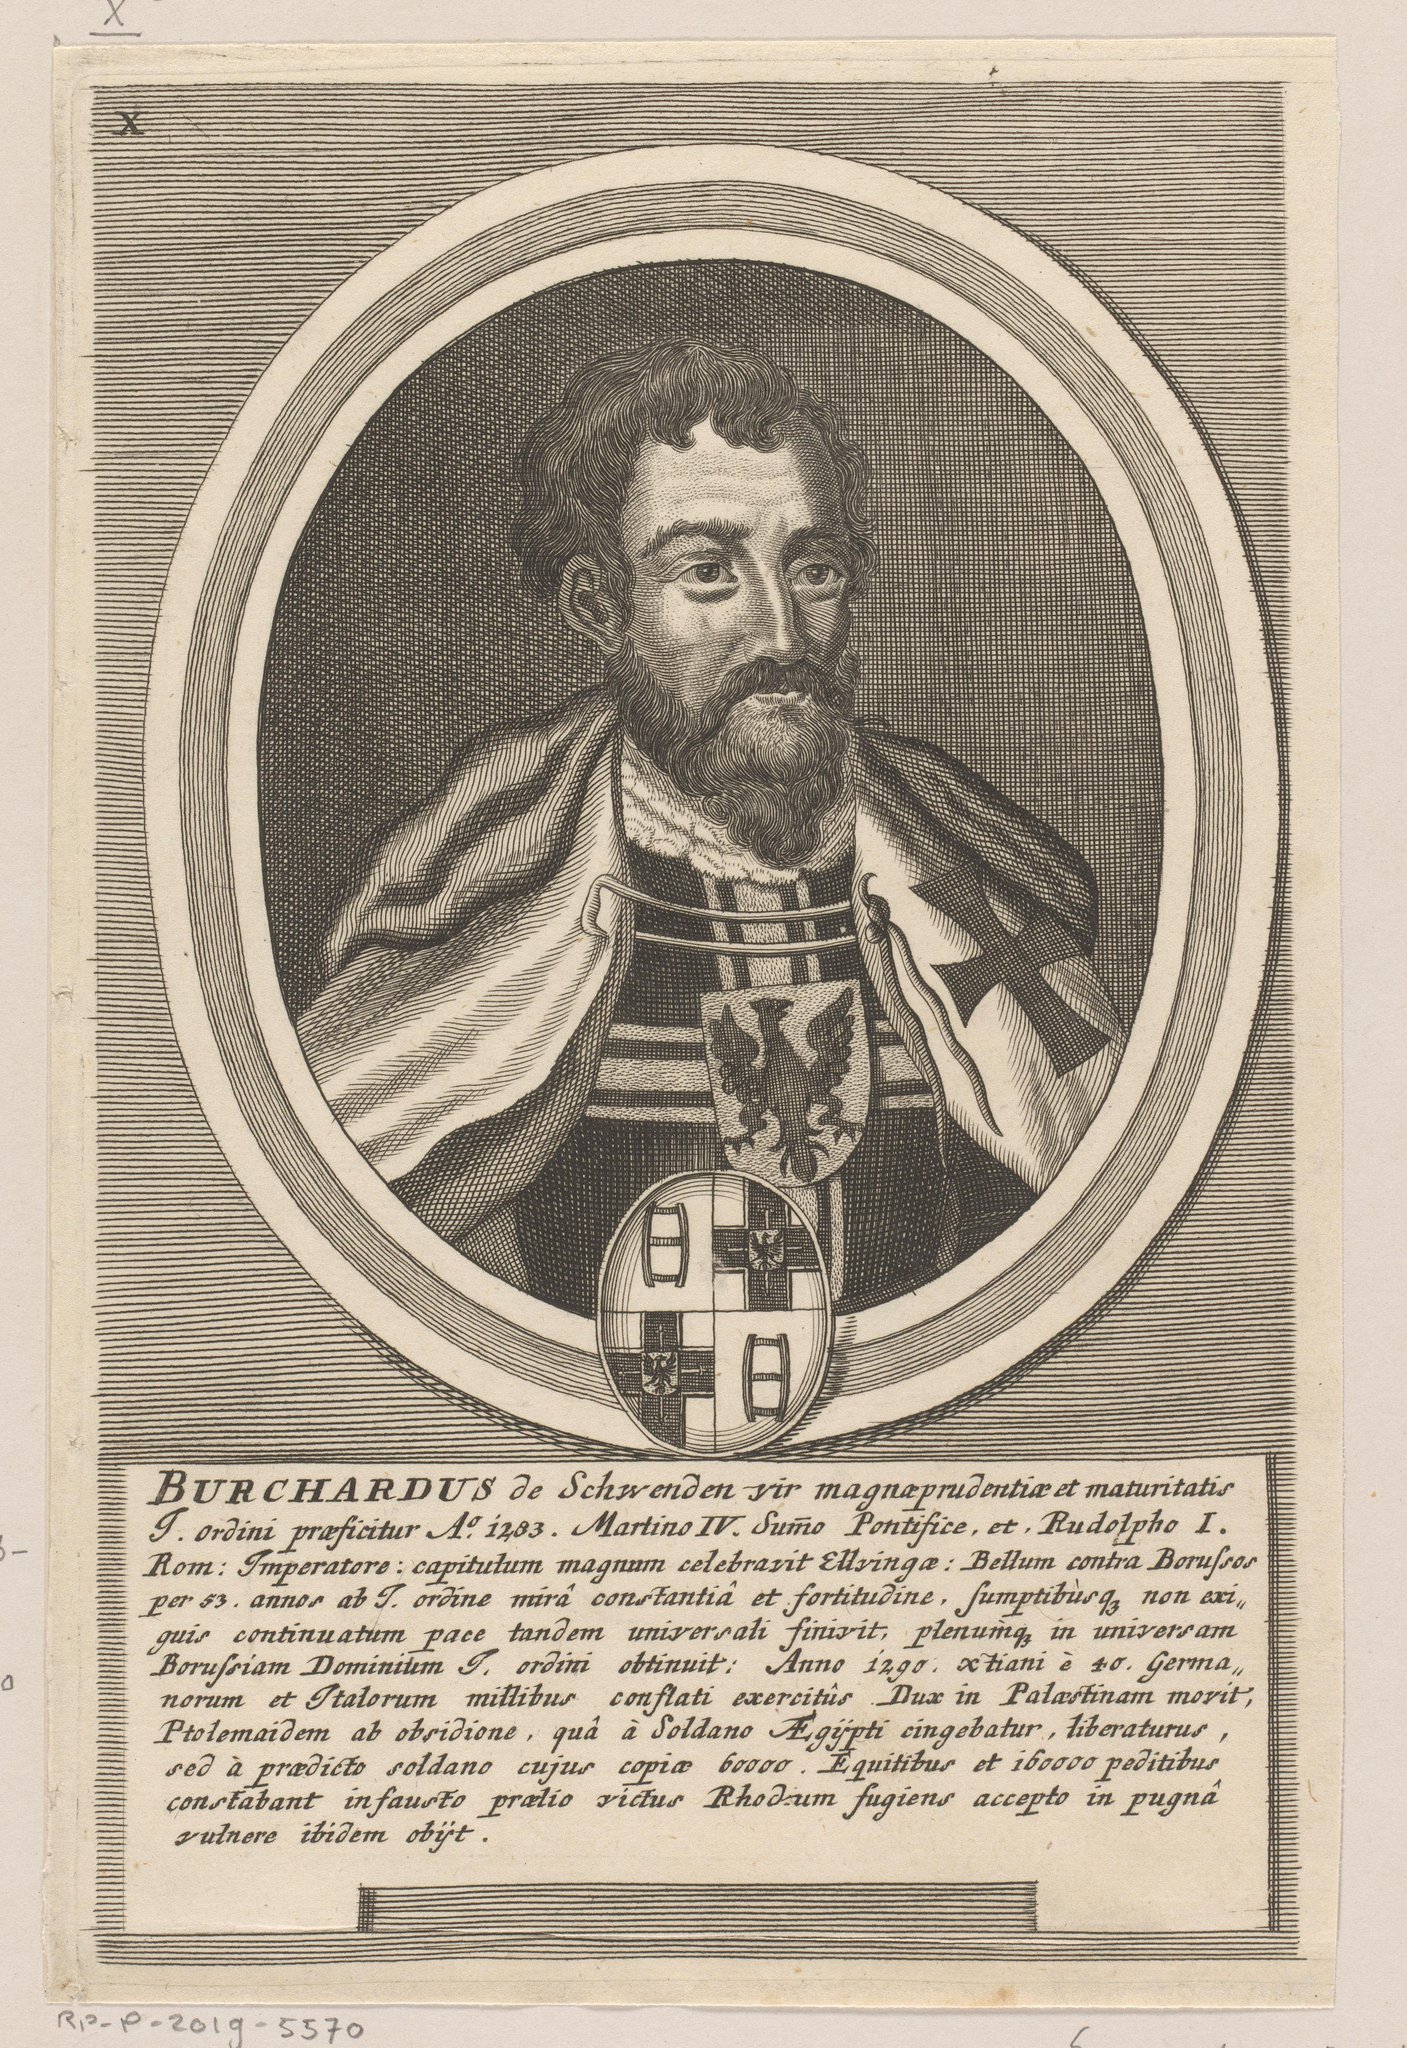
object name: print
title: Portret van Burchard von Schwanden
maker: johann salver (i)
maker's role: print maker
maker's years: 1670-1738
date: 1720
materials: paper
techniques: engraving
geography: würzburg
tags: knighthood order: teutonic order - insignia of a knighthood order, e.g.: badge, chain (with name of order), historical persons, armorial bearing, heraldry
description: Prent uit: [Salver, Johann]. De origine, secundis et adversis successibus, nec non de statu moderno inclyti ordinis equestris hospitalis b.m.v. Teutonicorum in Jerusalem. Würzburg: Johann Salver, [ca. 1720].